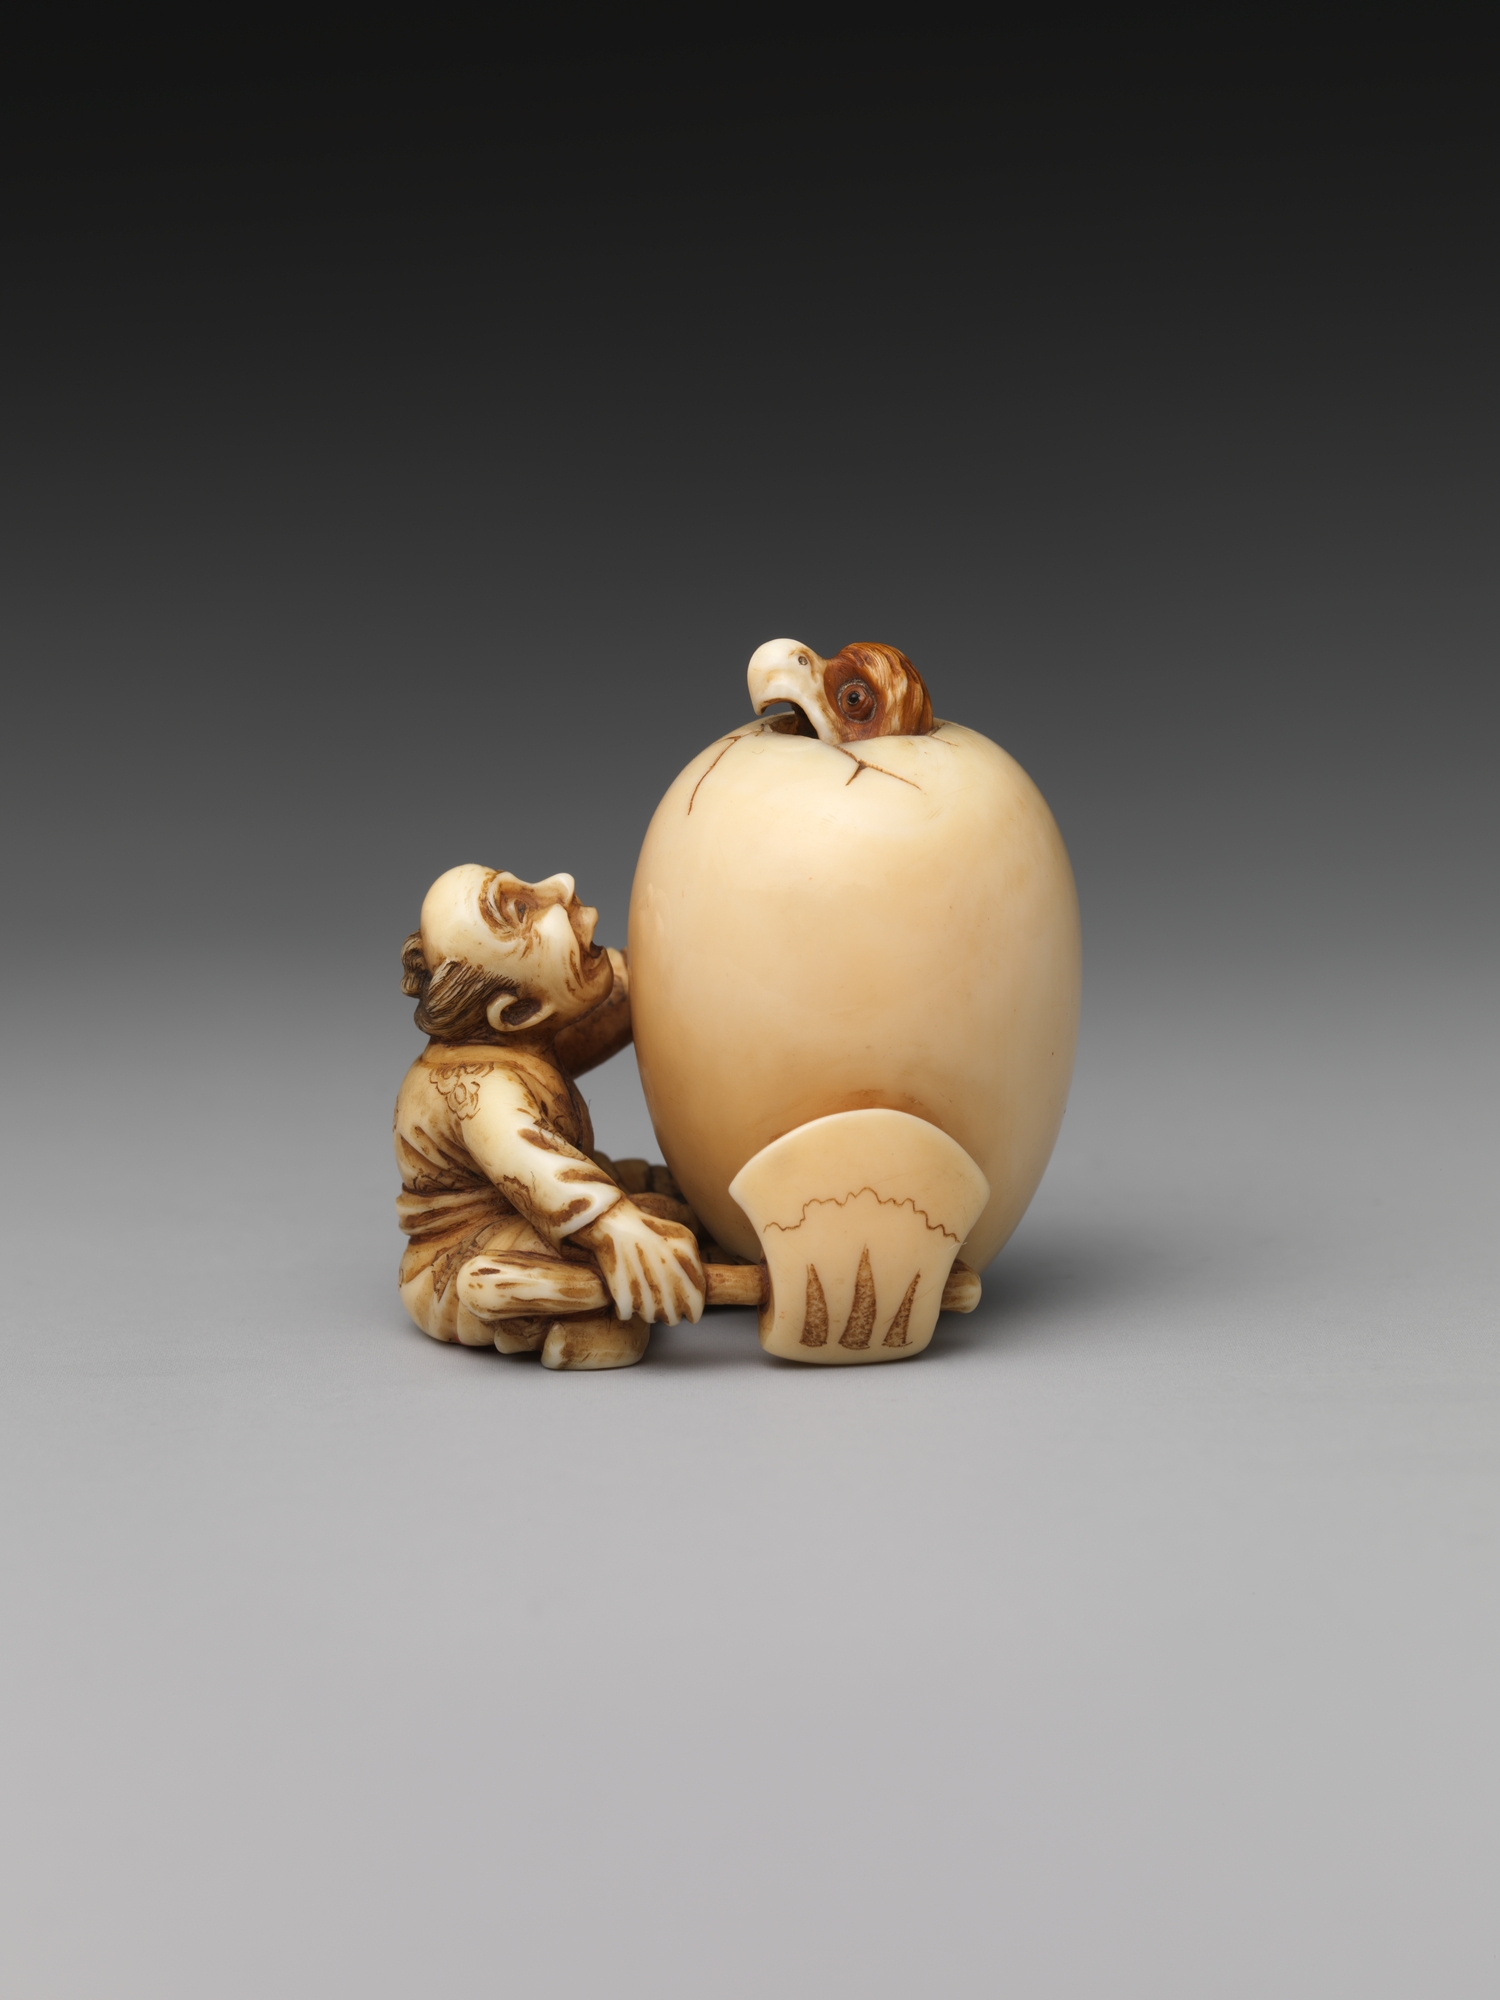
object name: netsuke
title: Netsuke of a Man and an Egg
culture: japanese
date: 1801-1900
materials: ivory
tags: birds,men,axes,eggs